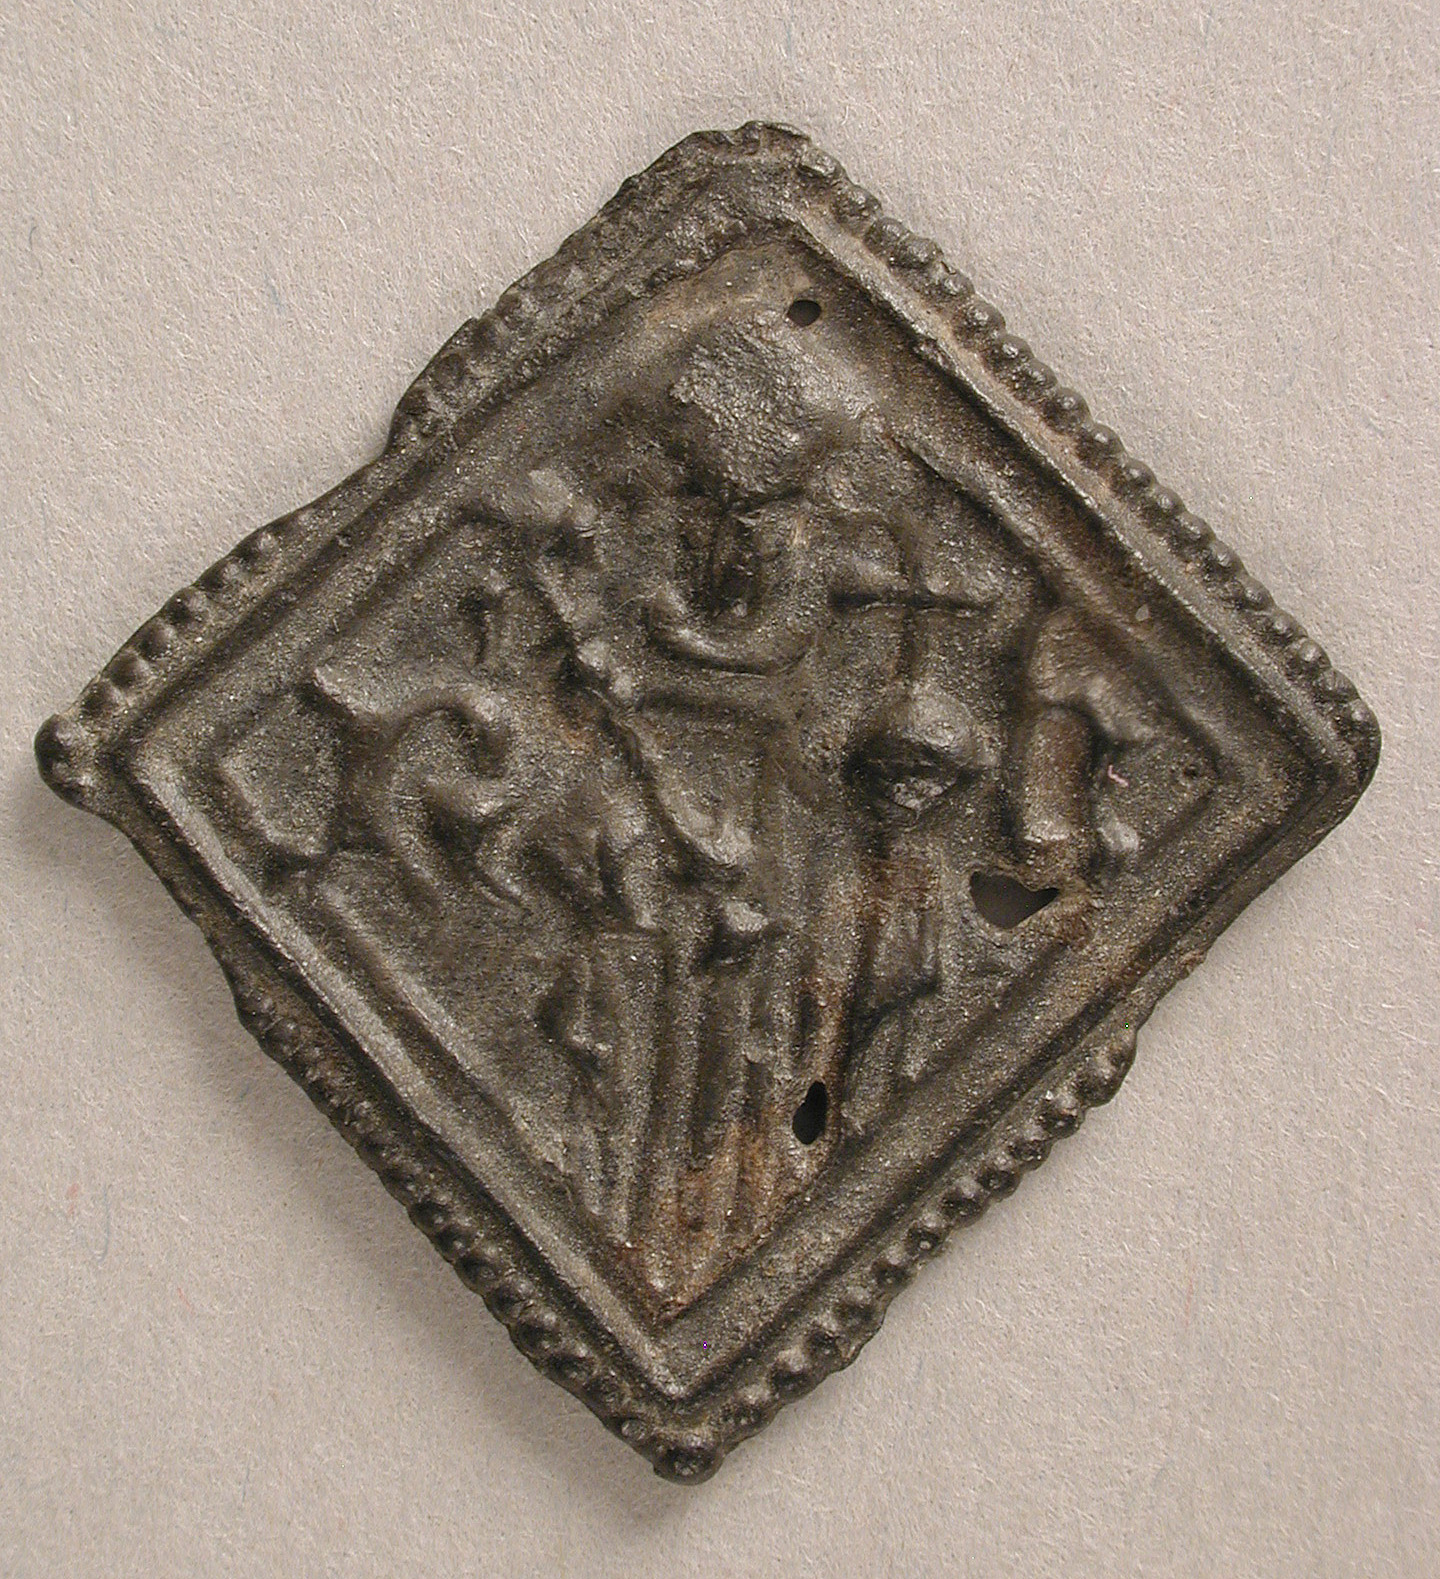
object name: pilgrim's badge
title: Badge of Henry VI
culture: british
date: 1401-1500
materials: alloy, lead, tin